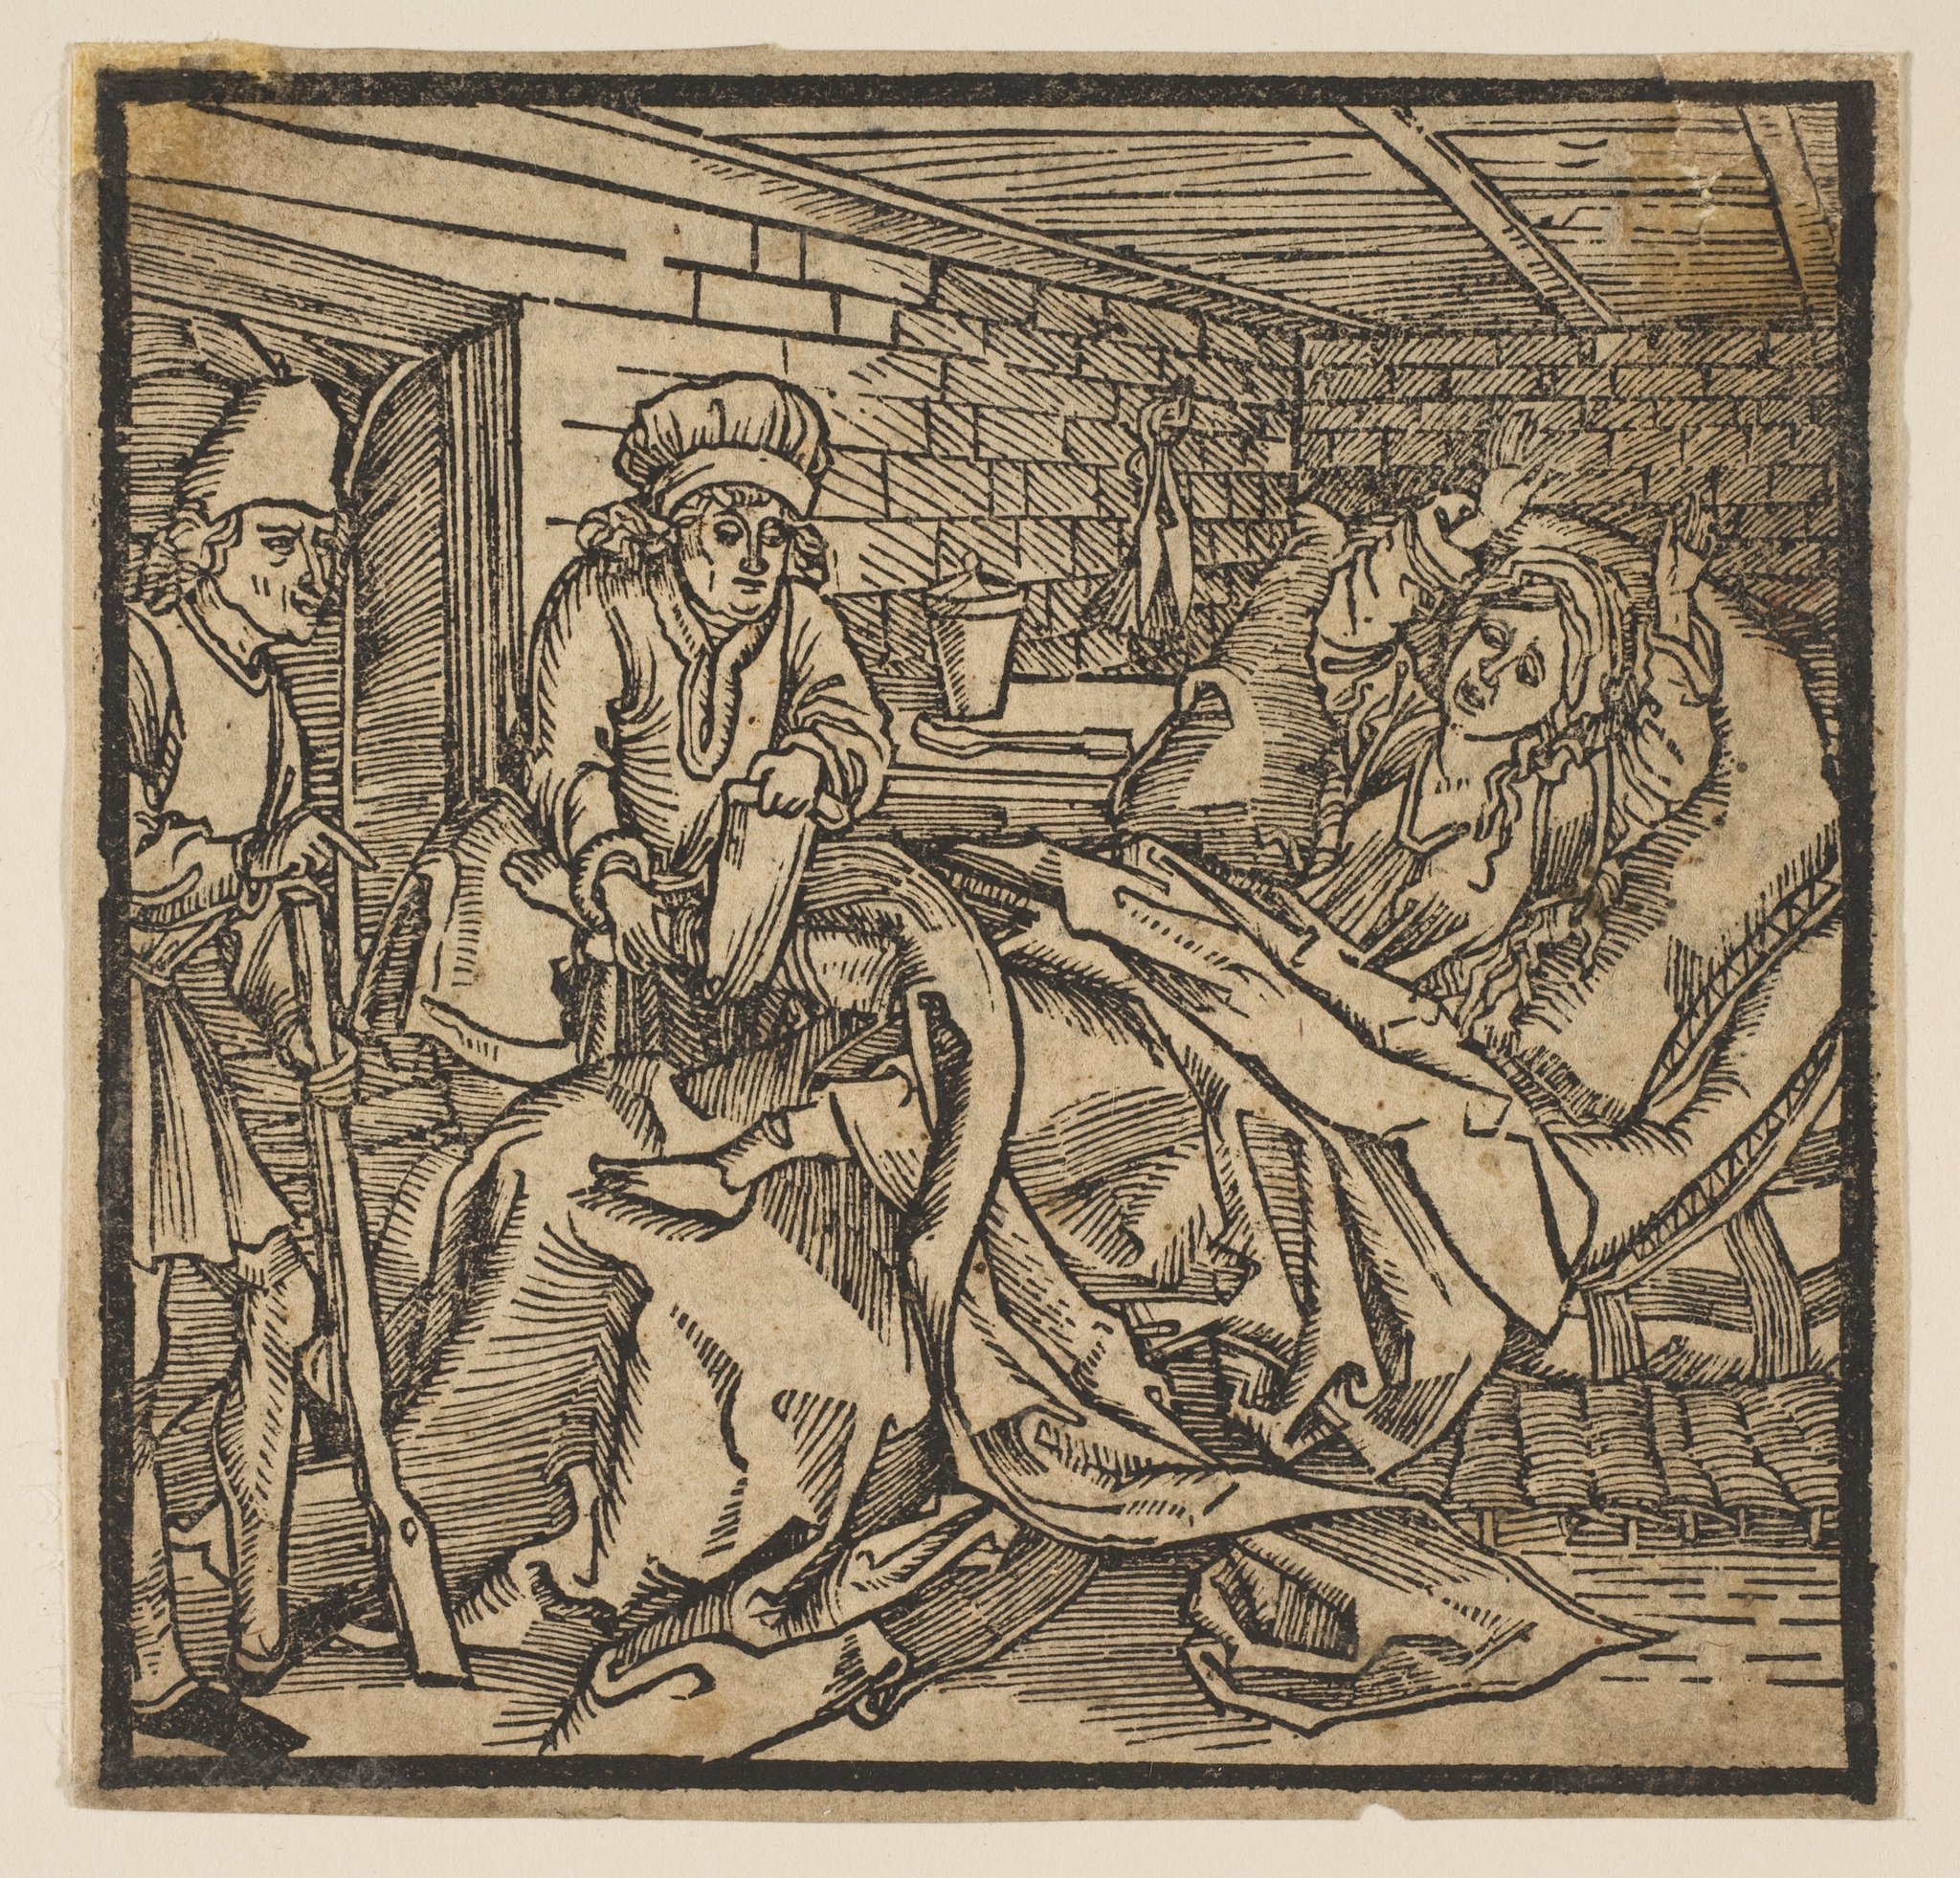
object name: print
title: Illustration from "The Ritter von Turn"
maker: albrecht dürer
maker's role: artist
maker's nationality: german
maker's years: 1471-1528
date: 1493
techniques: woodcut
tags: men,women